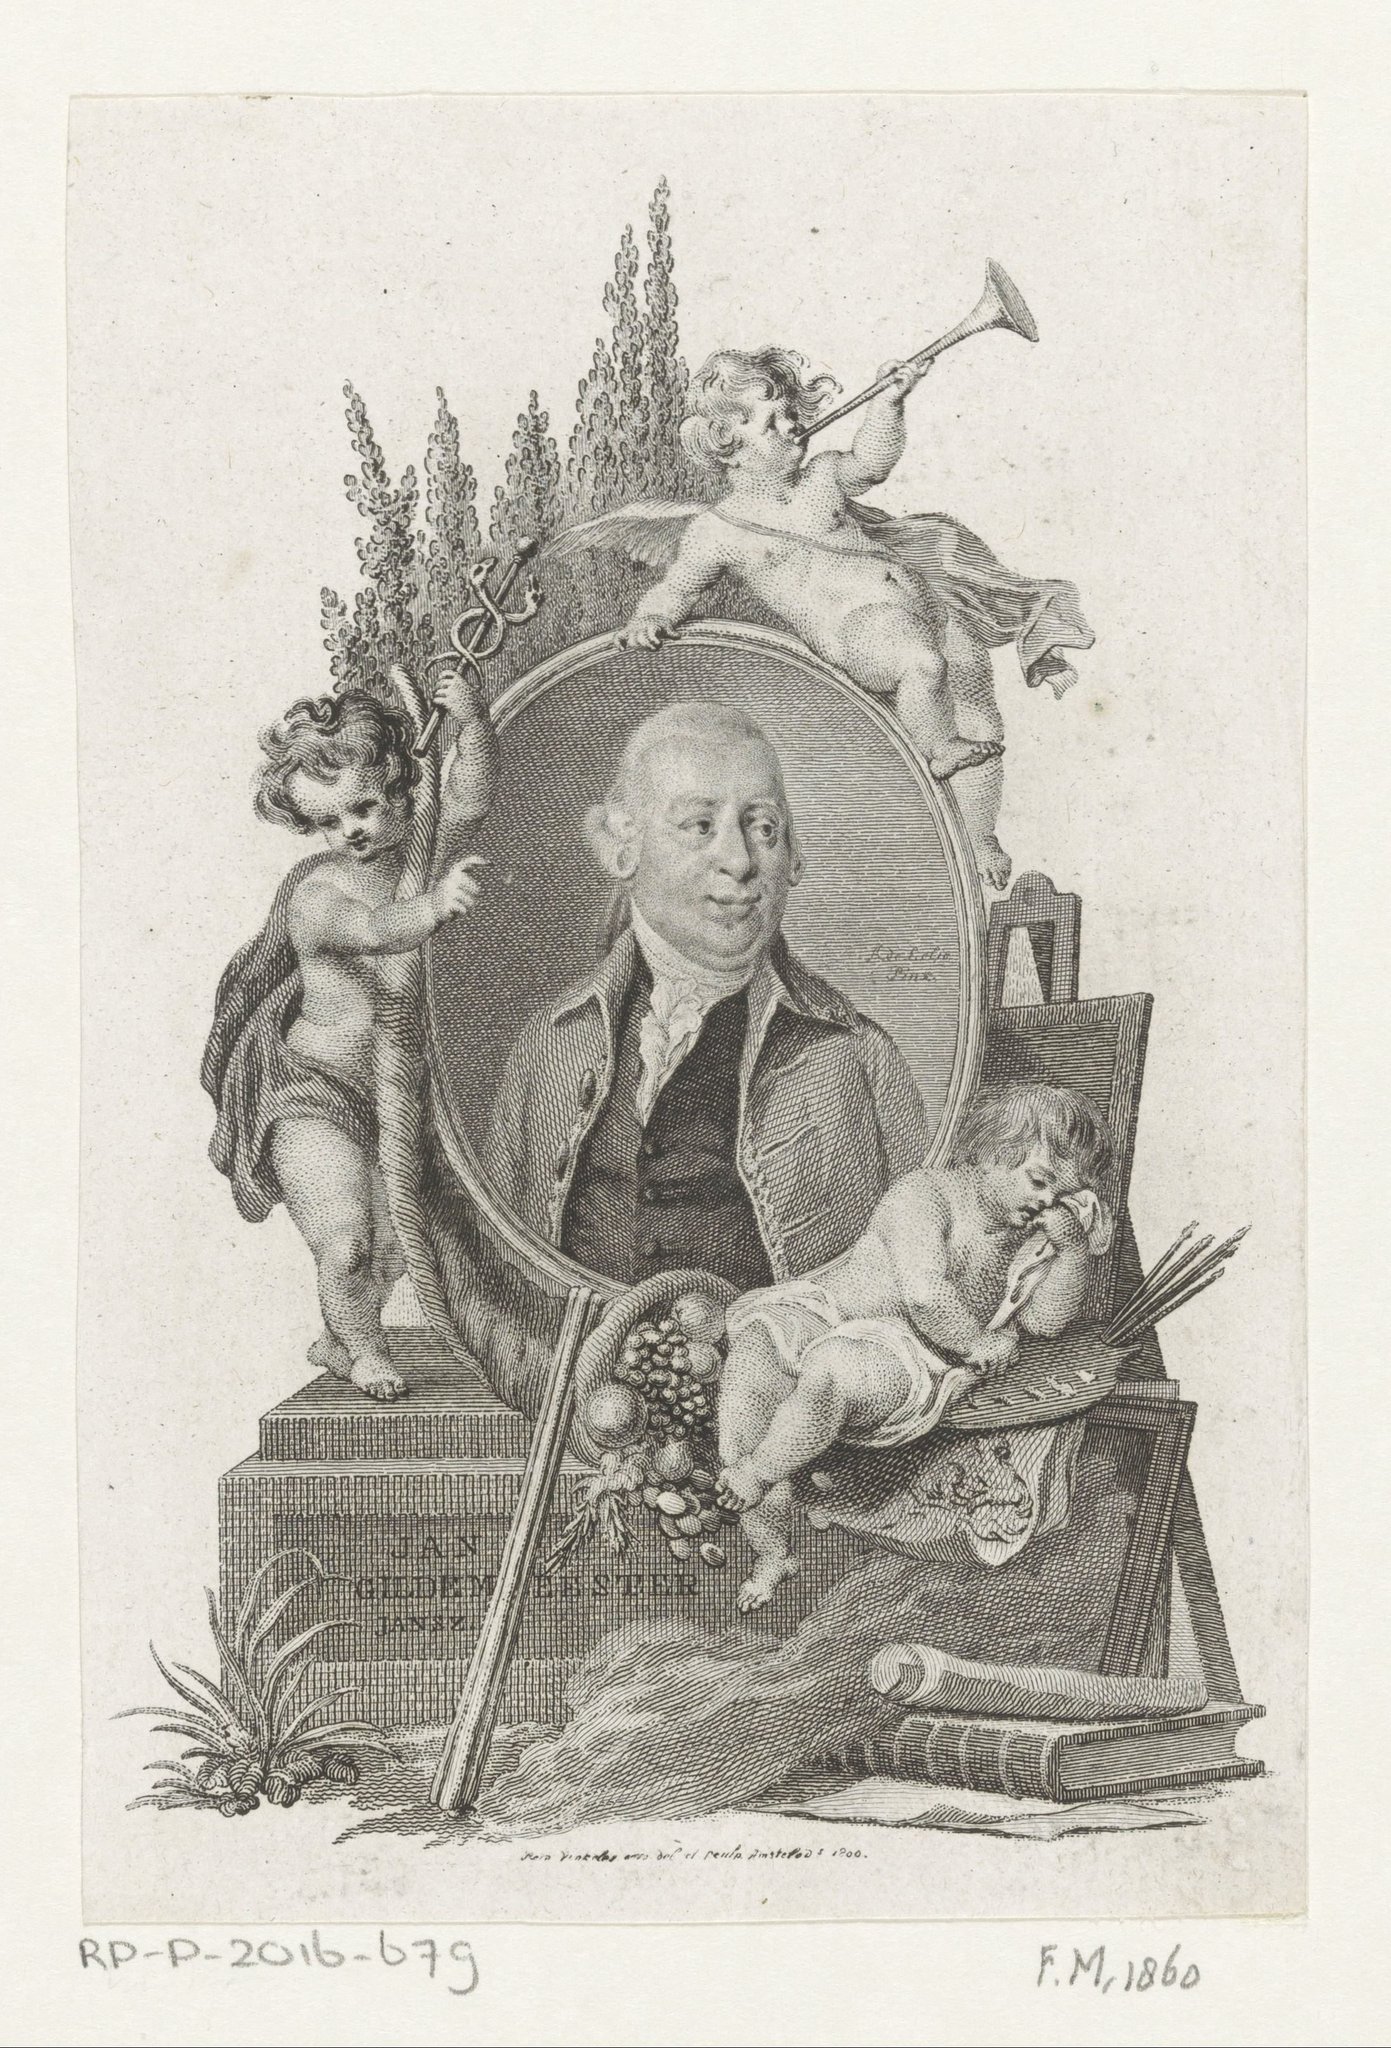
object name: print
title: Portret van Jan Gildemeester Jansz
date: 1800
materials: paper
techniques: engraving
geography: amsterdam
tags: art collector, cupids: 'amores', 'amoretti', 'putti'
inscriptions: collector's mark: Lugt 2228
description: Portret van de Amsterdamse kunstliefhebber Jan Gildemeester Jansz in een ovaal medaillon op een sokkel. Bovenaan een putto blazend op een bazuin, links een putto met caduceus en rechts een treurende putto bij schildersattributen als palet, penselen en schildersezel met naast hem en hoorn des overvloeds. Tegen de sokkel rust een uitgedoofde fakkel.